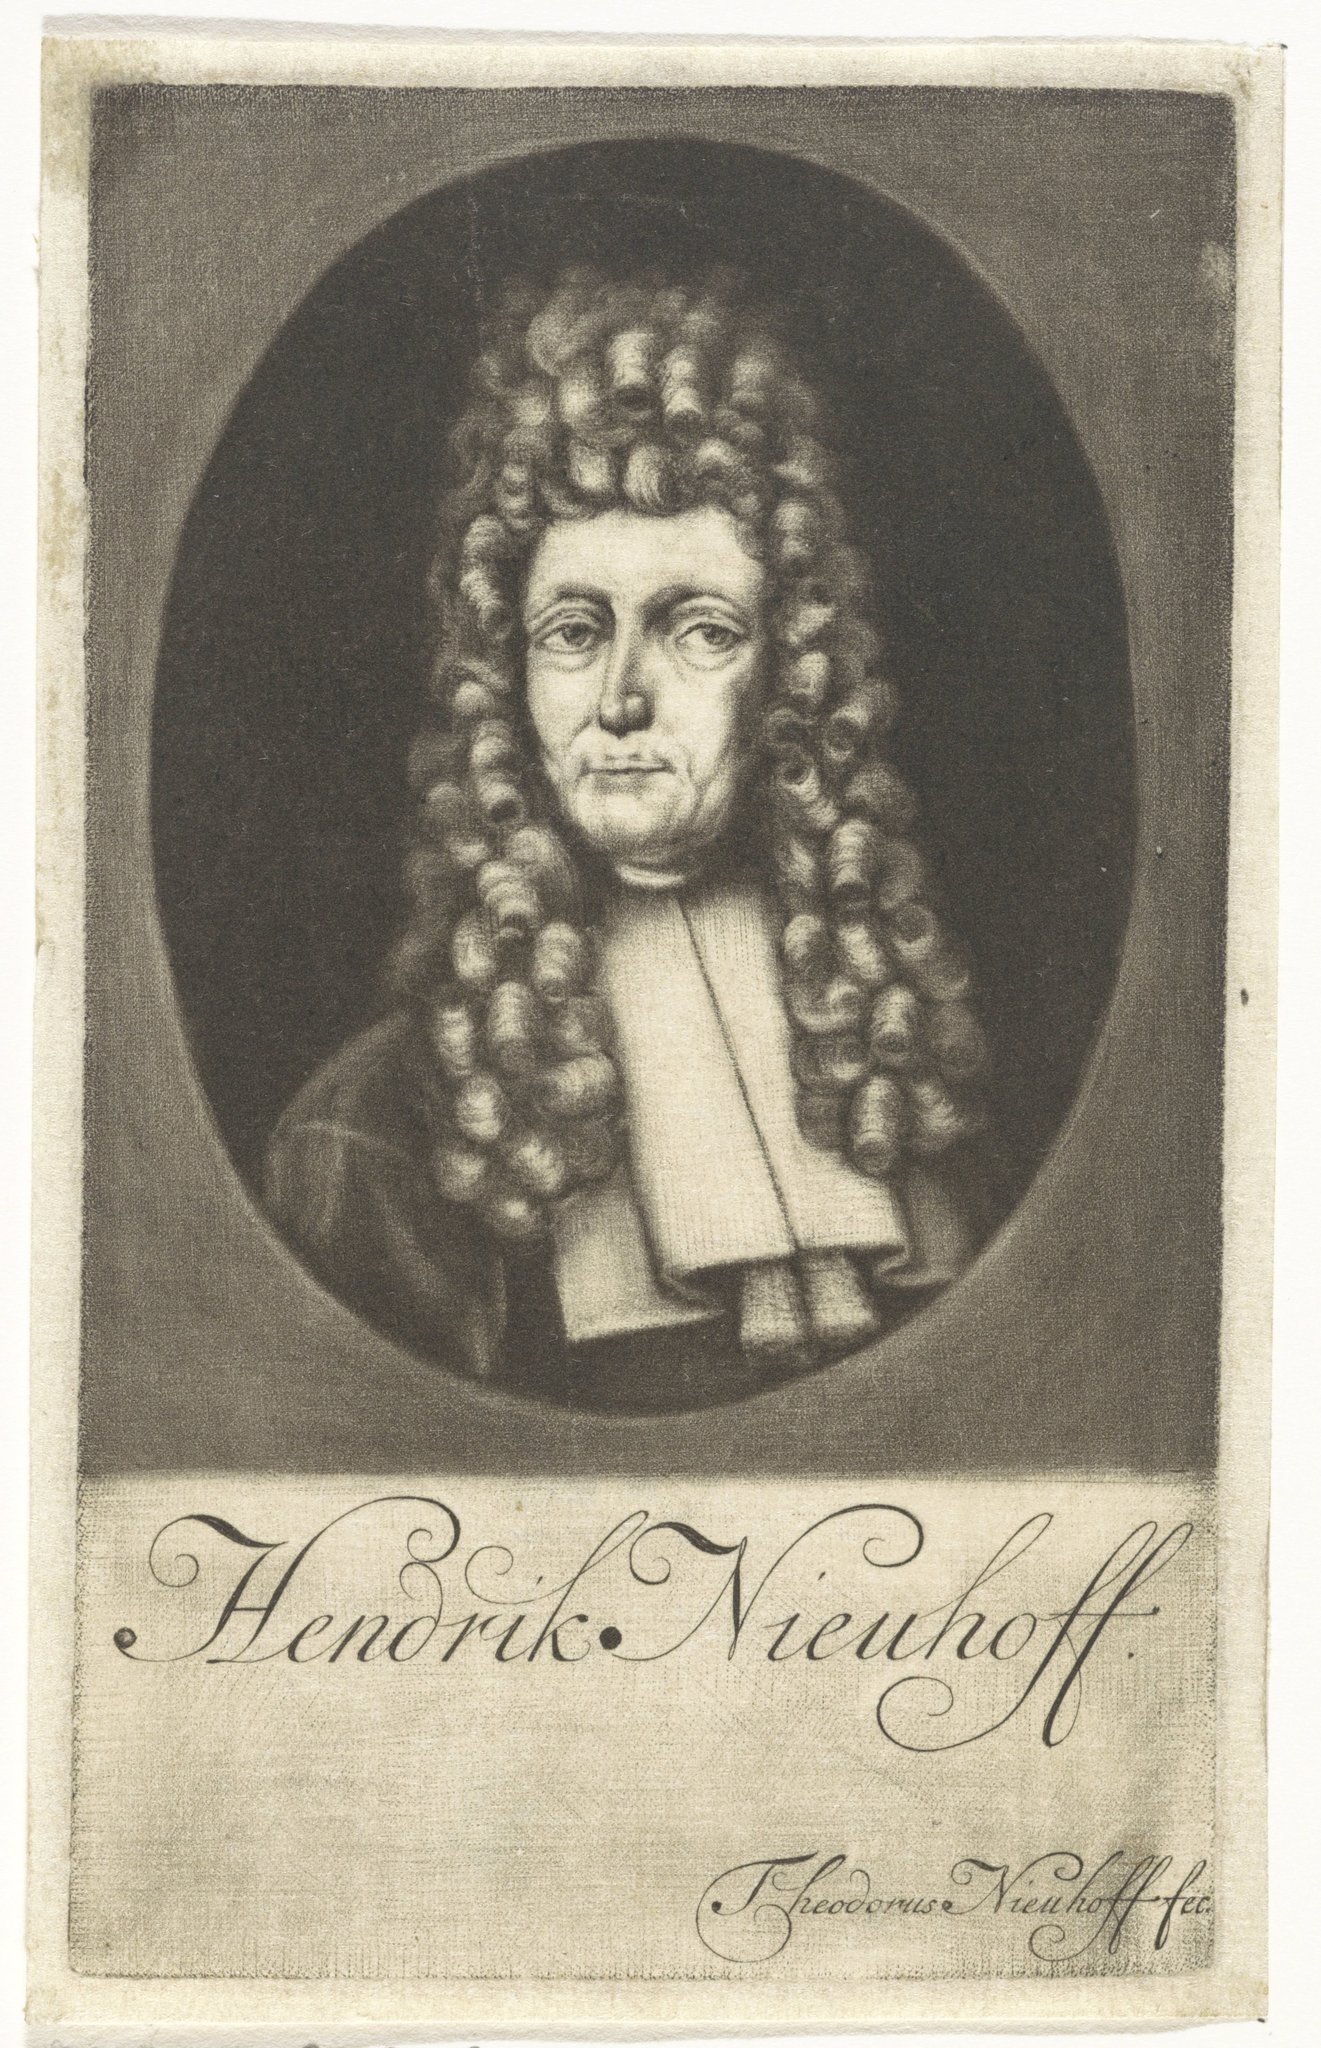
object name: print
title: Portret van Hendrik Nieuhoff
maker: theodorus nieuhoff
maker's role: print maker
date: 1670-1690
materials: paper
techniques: engraving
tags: wig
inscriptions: collector's mark: Lugt 2228